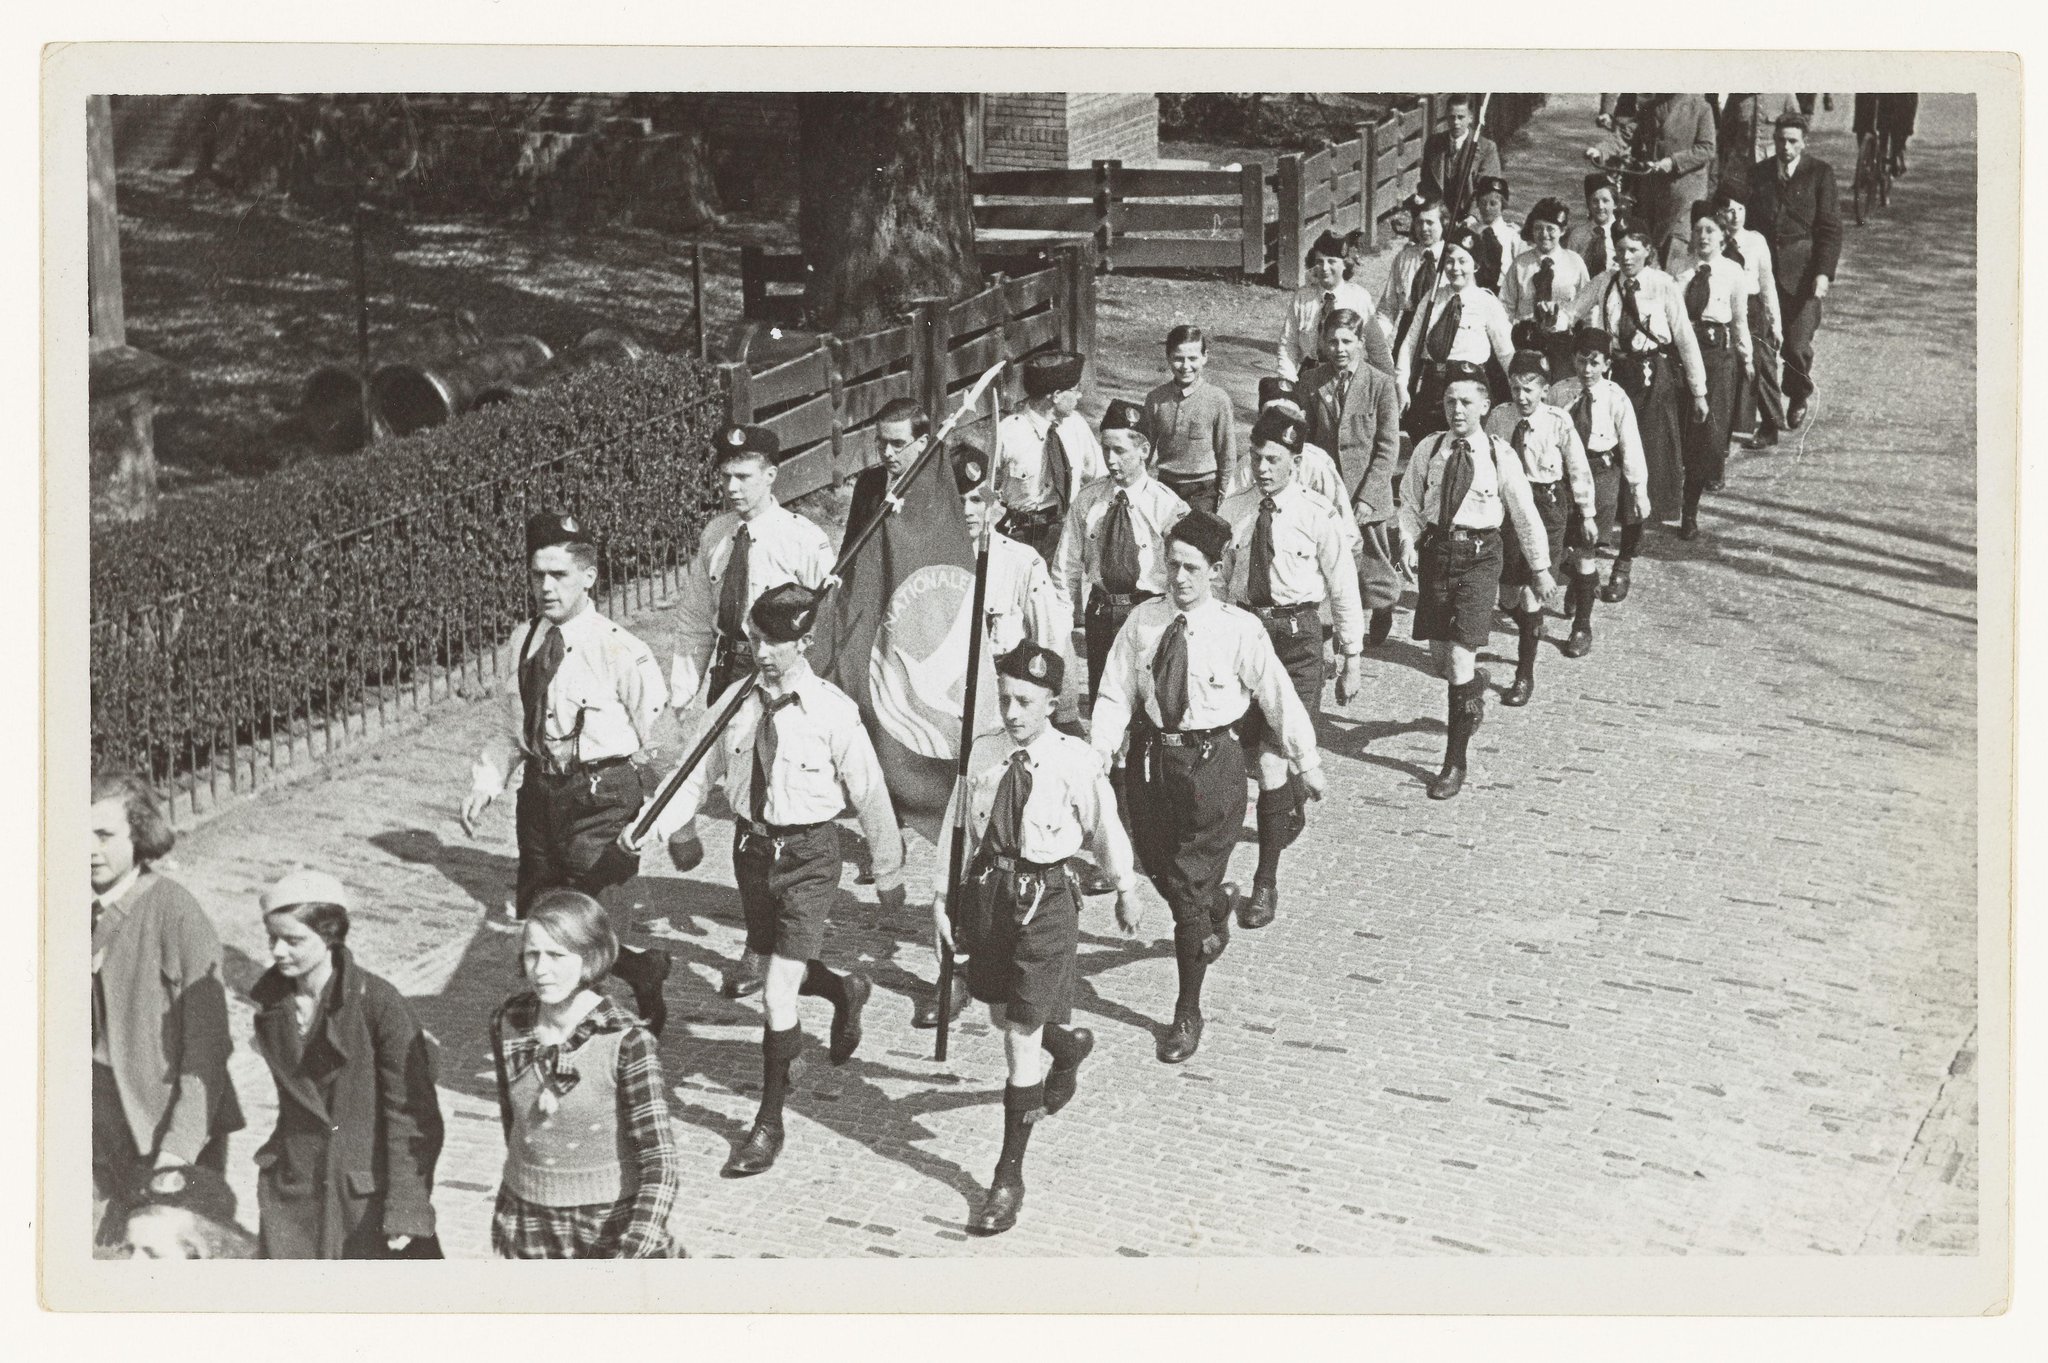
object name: photograph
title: Optocht Jeugdstorm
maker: j. otto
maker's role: fotograaf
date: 1935-1937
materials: photographic support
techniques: gelatin silver print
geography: zeist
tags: military parade, pageant, zeist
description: Groep van de Jeugdstorm, loopt door een straat. Een jongen draagt de vlag van de Jeugdstorm met bovenop de stok als versiering een vliegende meeuw. De meeste jongens zijn in uniform. Voor de groep met de vlag lopen een paar meisjes zonder uniform.